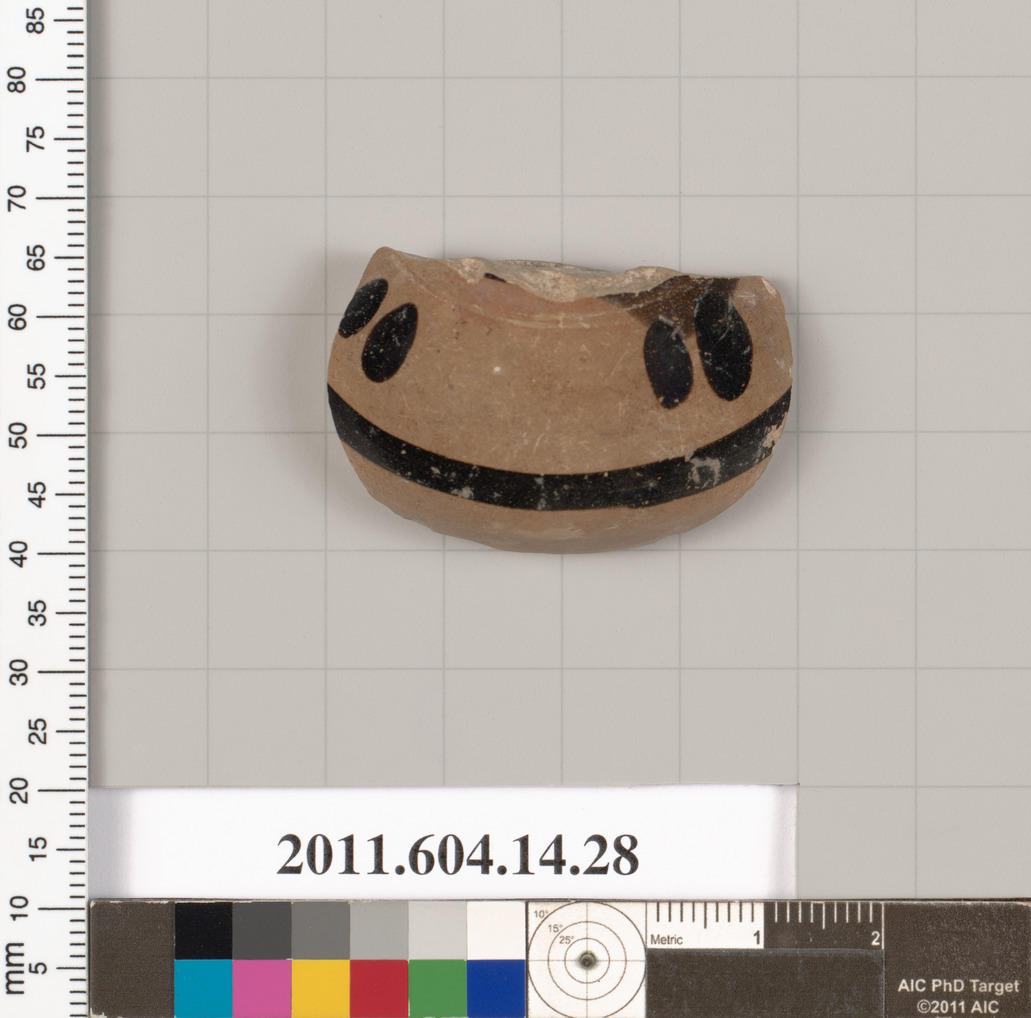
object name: knob fragment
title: Part of the knob of a terracotta lid?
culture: unknown fabric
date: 600-401 BCE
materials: terracotta